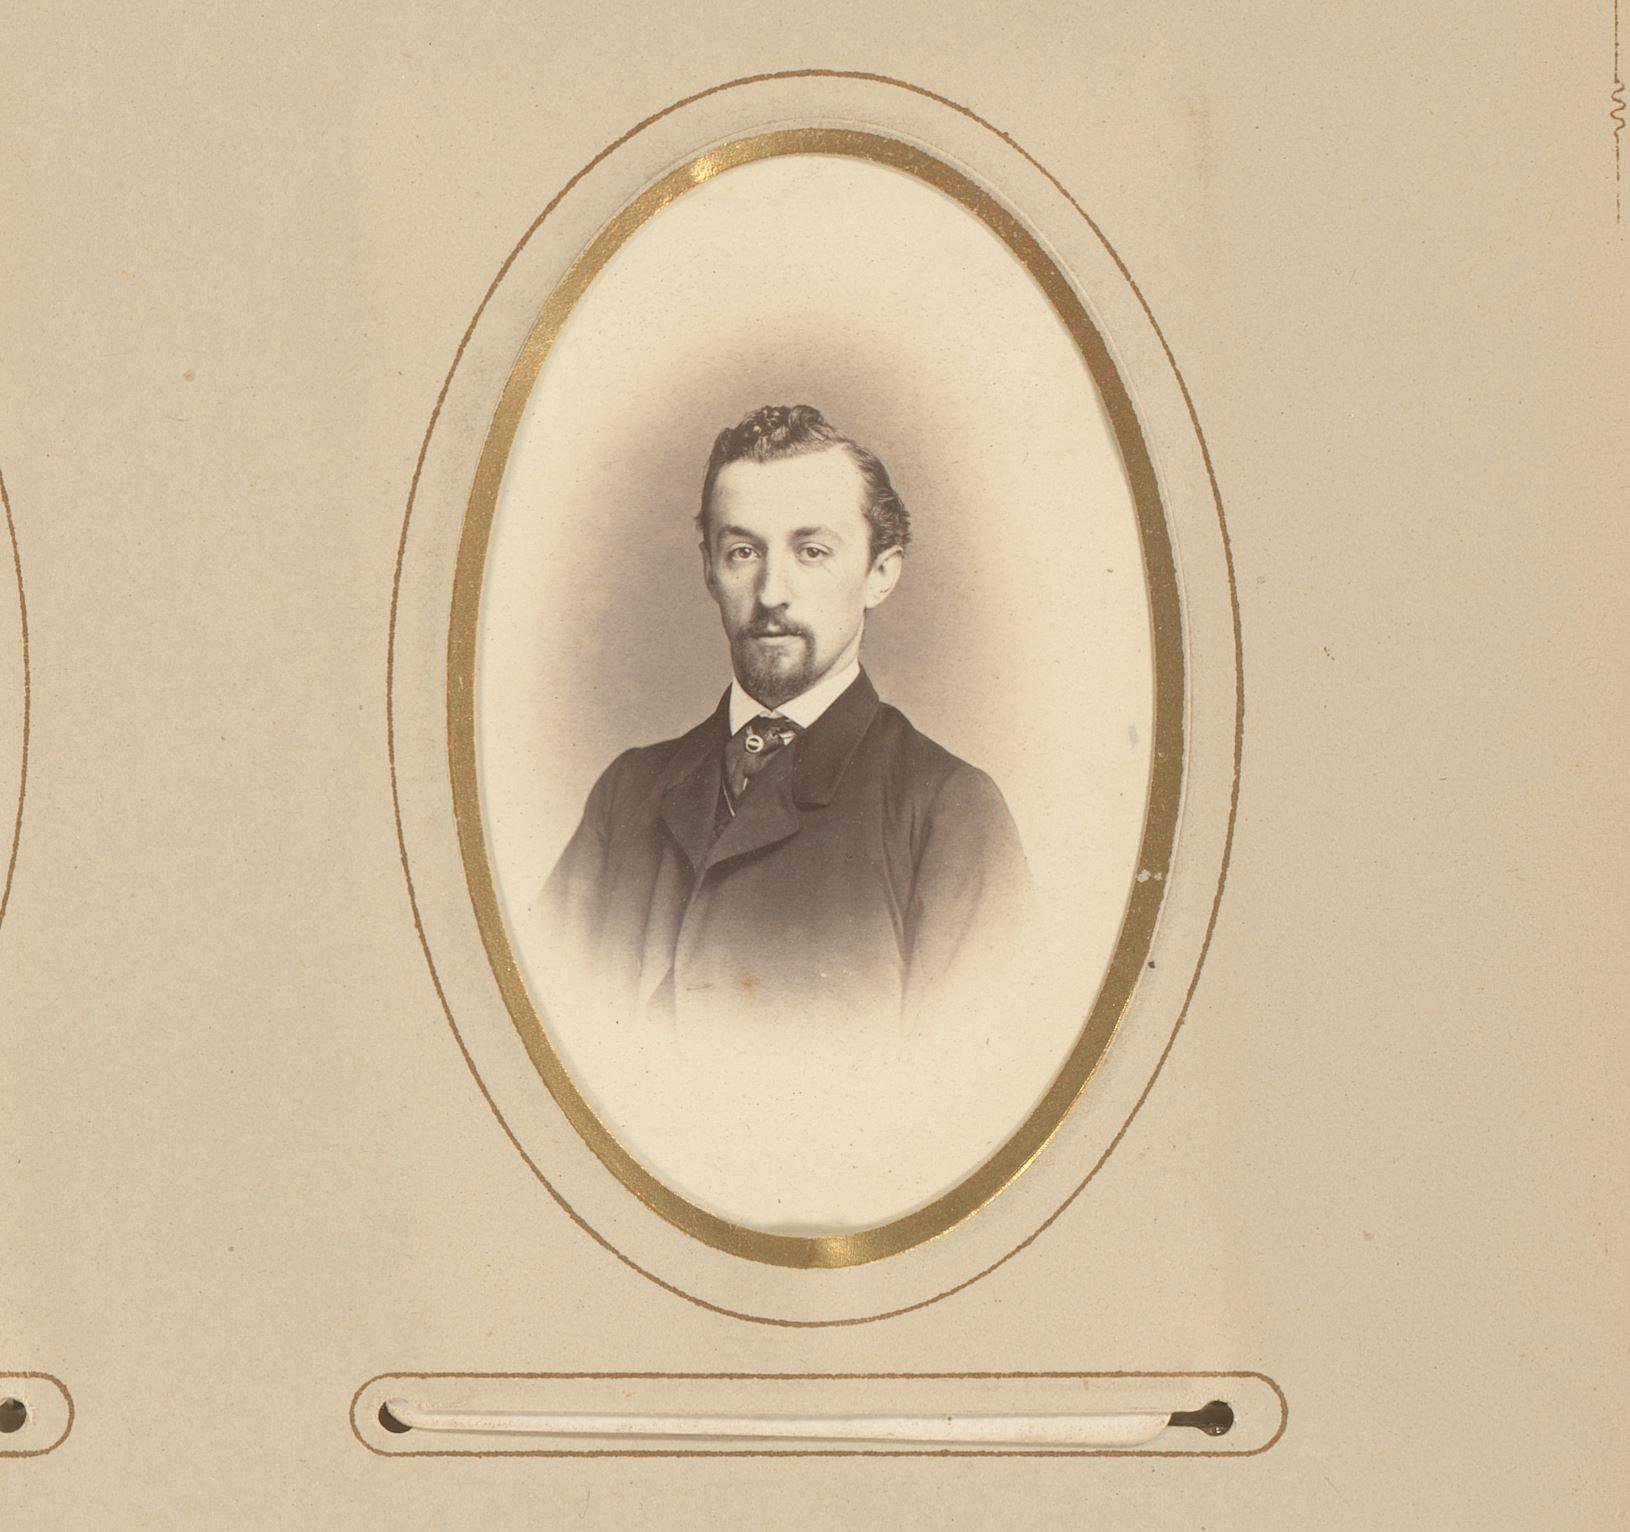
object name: photograph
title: Portret van een man met snor en baard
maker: f. springmeier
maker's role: fotograaf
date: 1850-1900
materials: cardboard, photographic support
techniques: albumen print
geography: elberfeld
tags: moustache, historical persons, beard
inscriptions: inscription: ‘F. Springmeier/ PHOTOGRAPH/ Elberfeld/ Herzogstrasse, No. 4.’